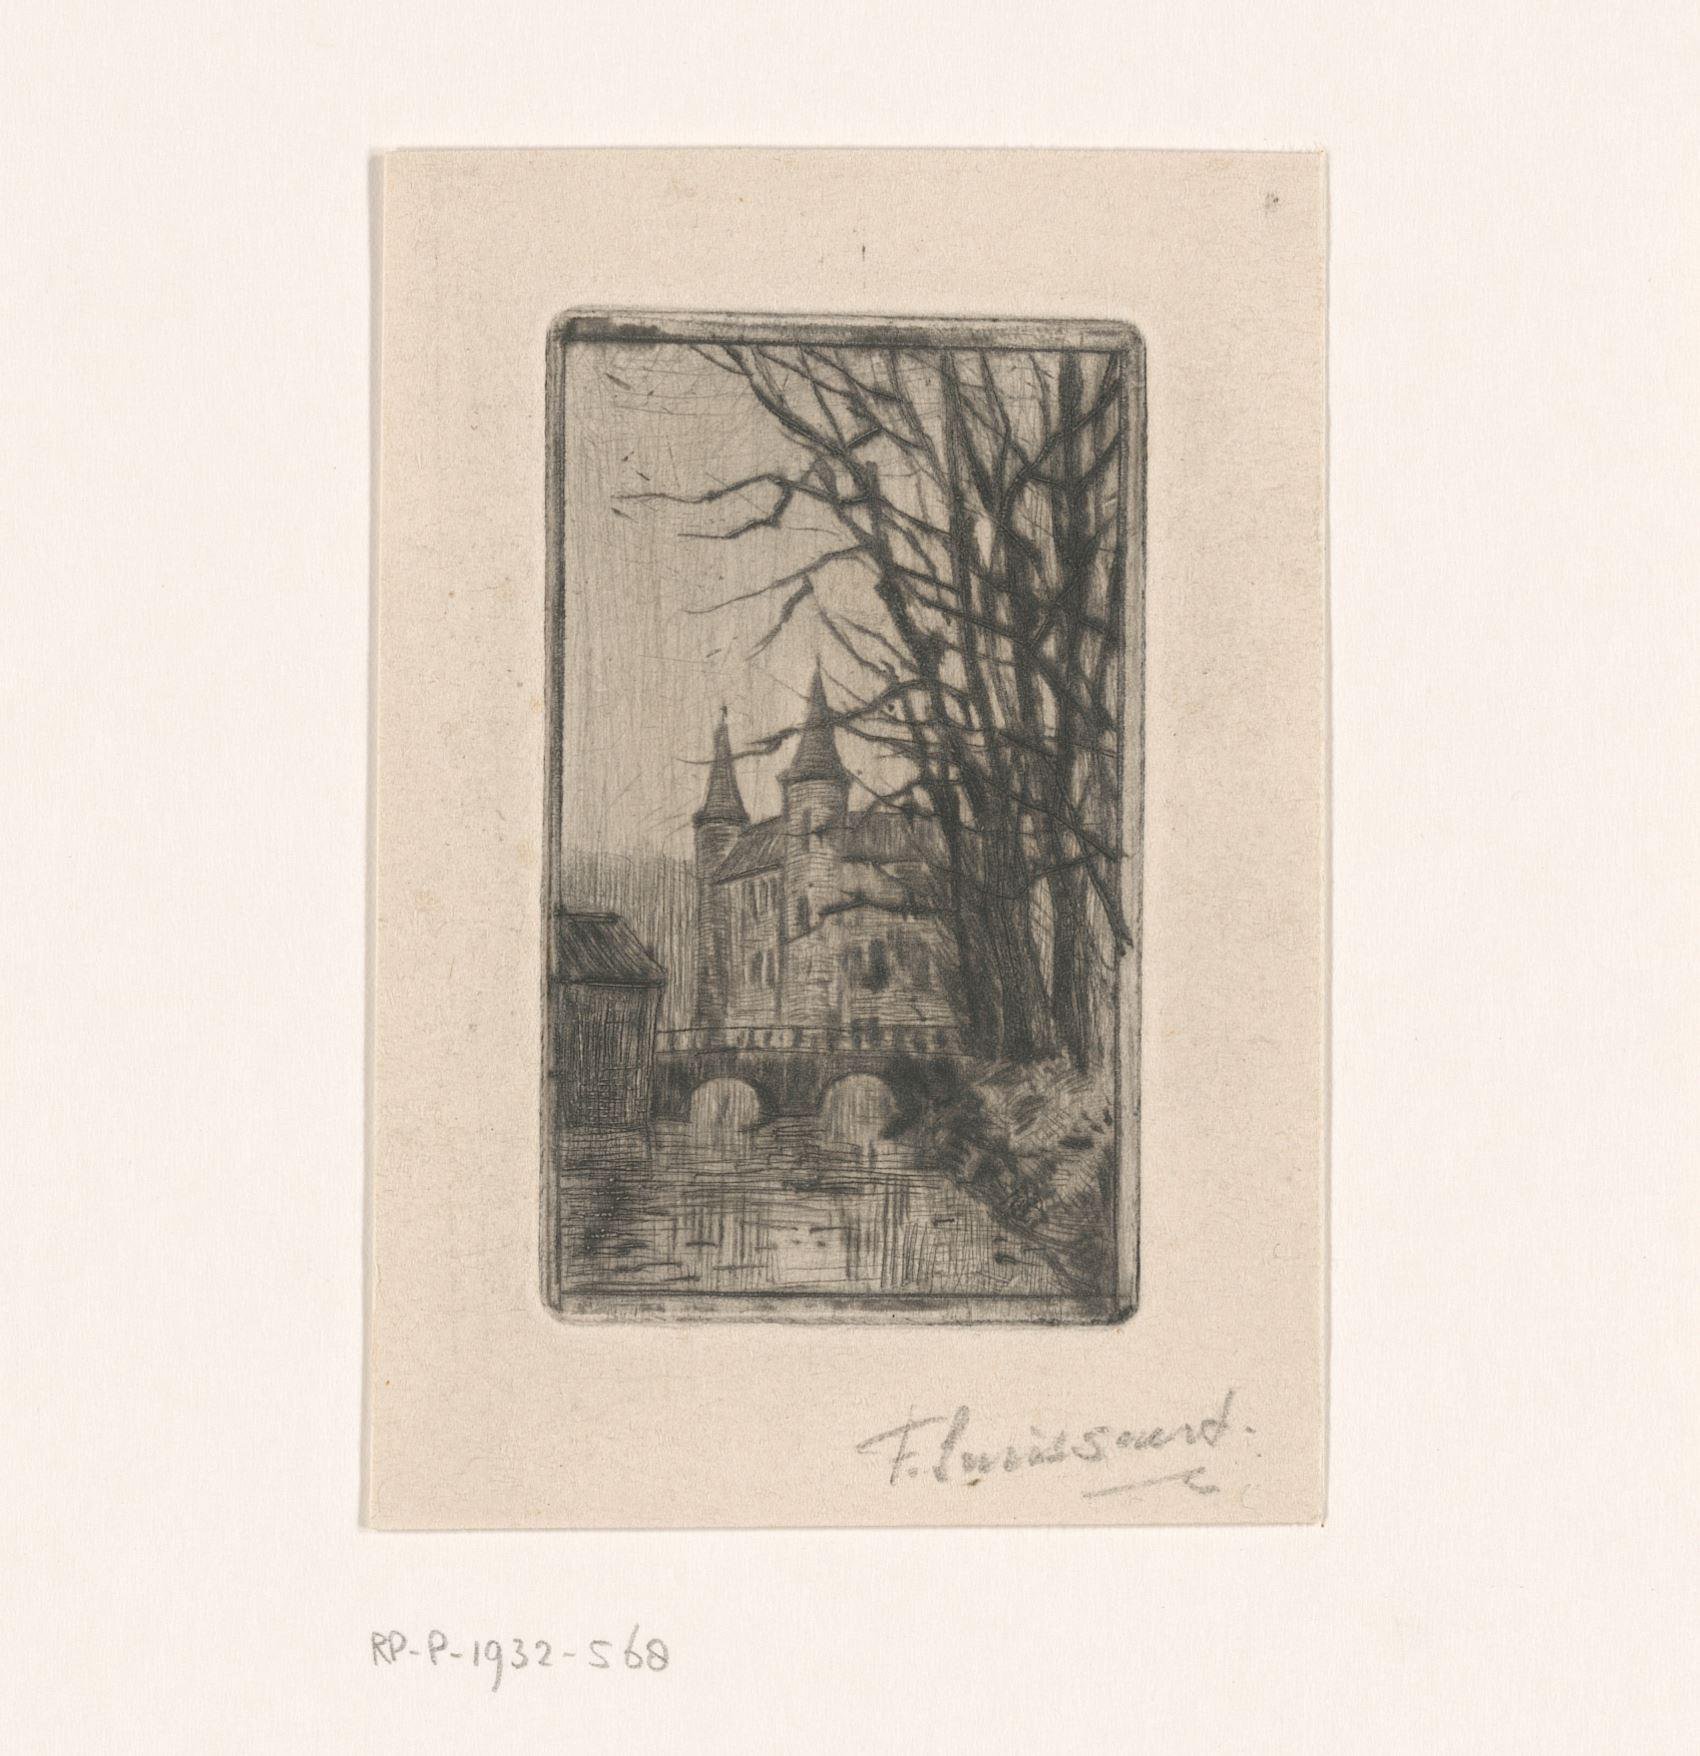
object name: print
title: Kasteel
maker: frans smissaert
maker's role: draughtsman, print maker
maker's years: 1862-1944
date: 1872-1932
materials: paper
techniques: etching, intaglio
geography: netherlands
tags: castle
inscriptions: collector's mark: Lugt 2228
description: Gezicht op een kasteel achter een brug. Rechts staat een boomgroep op de oever.